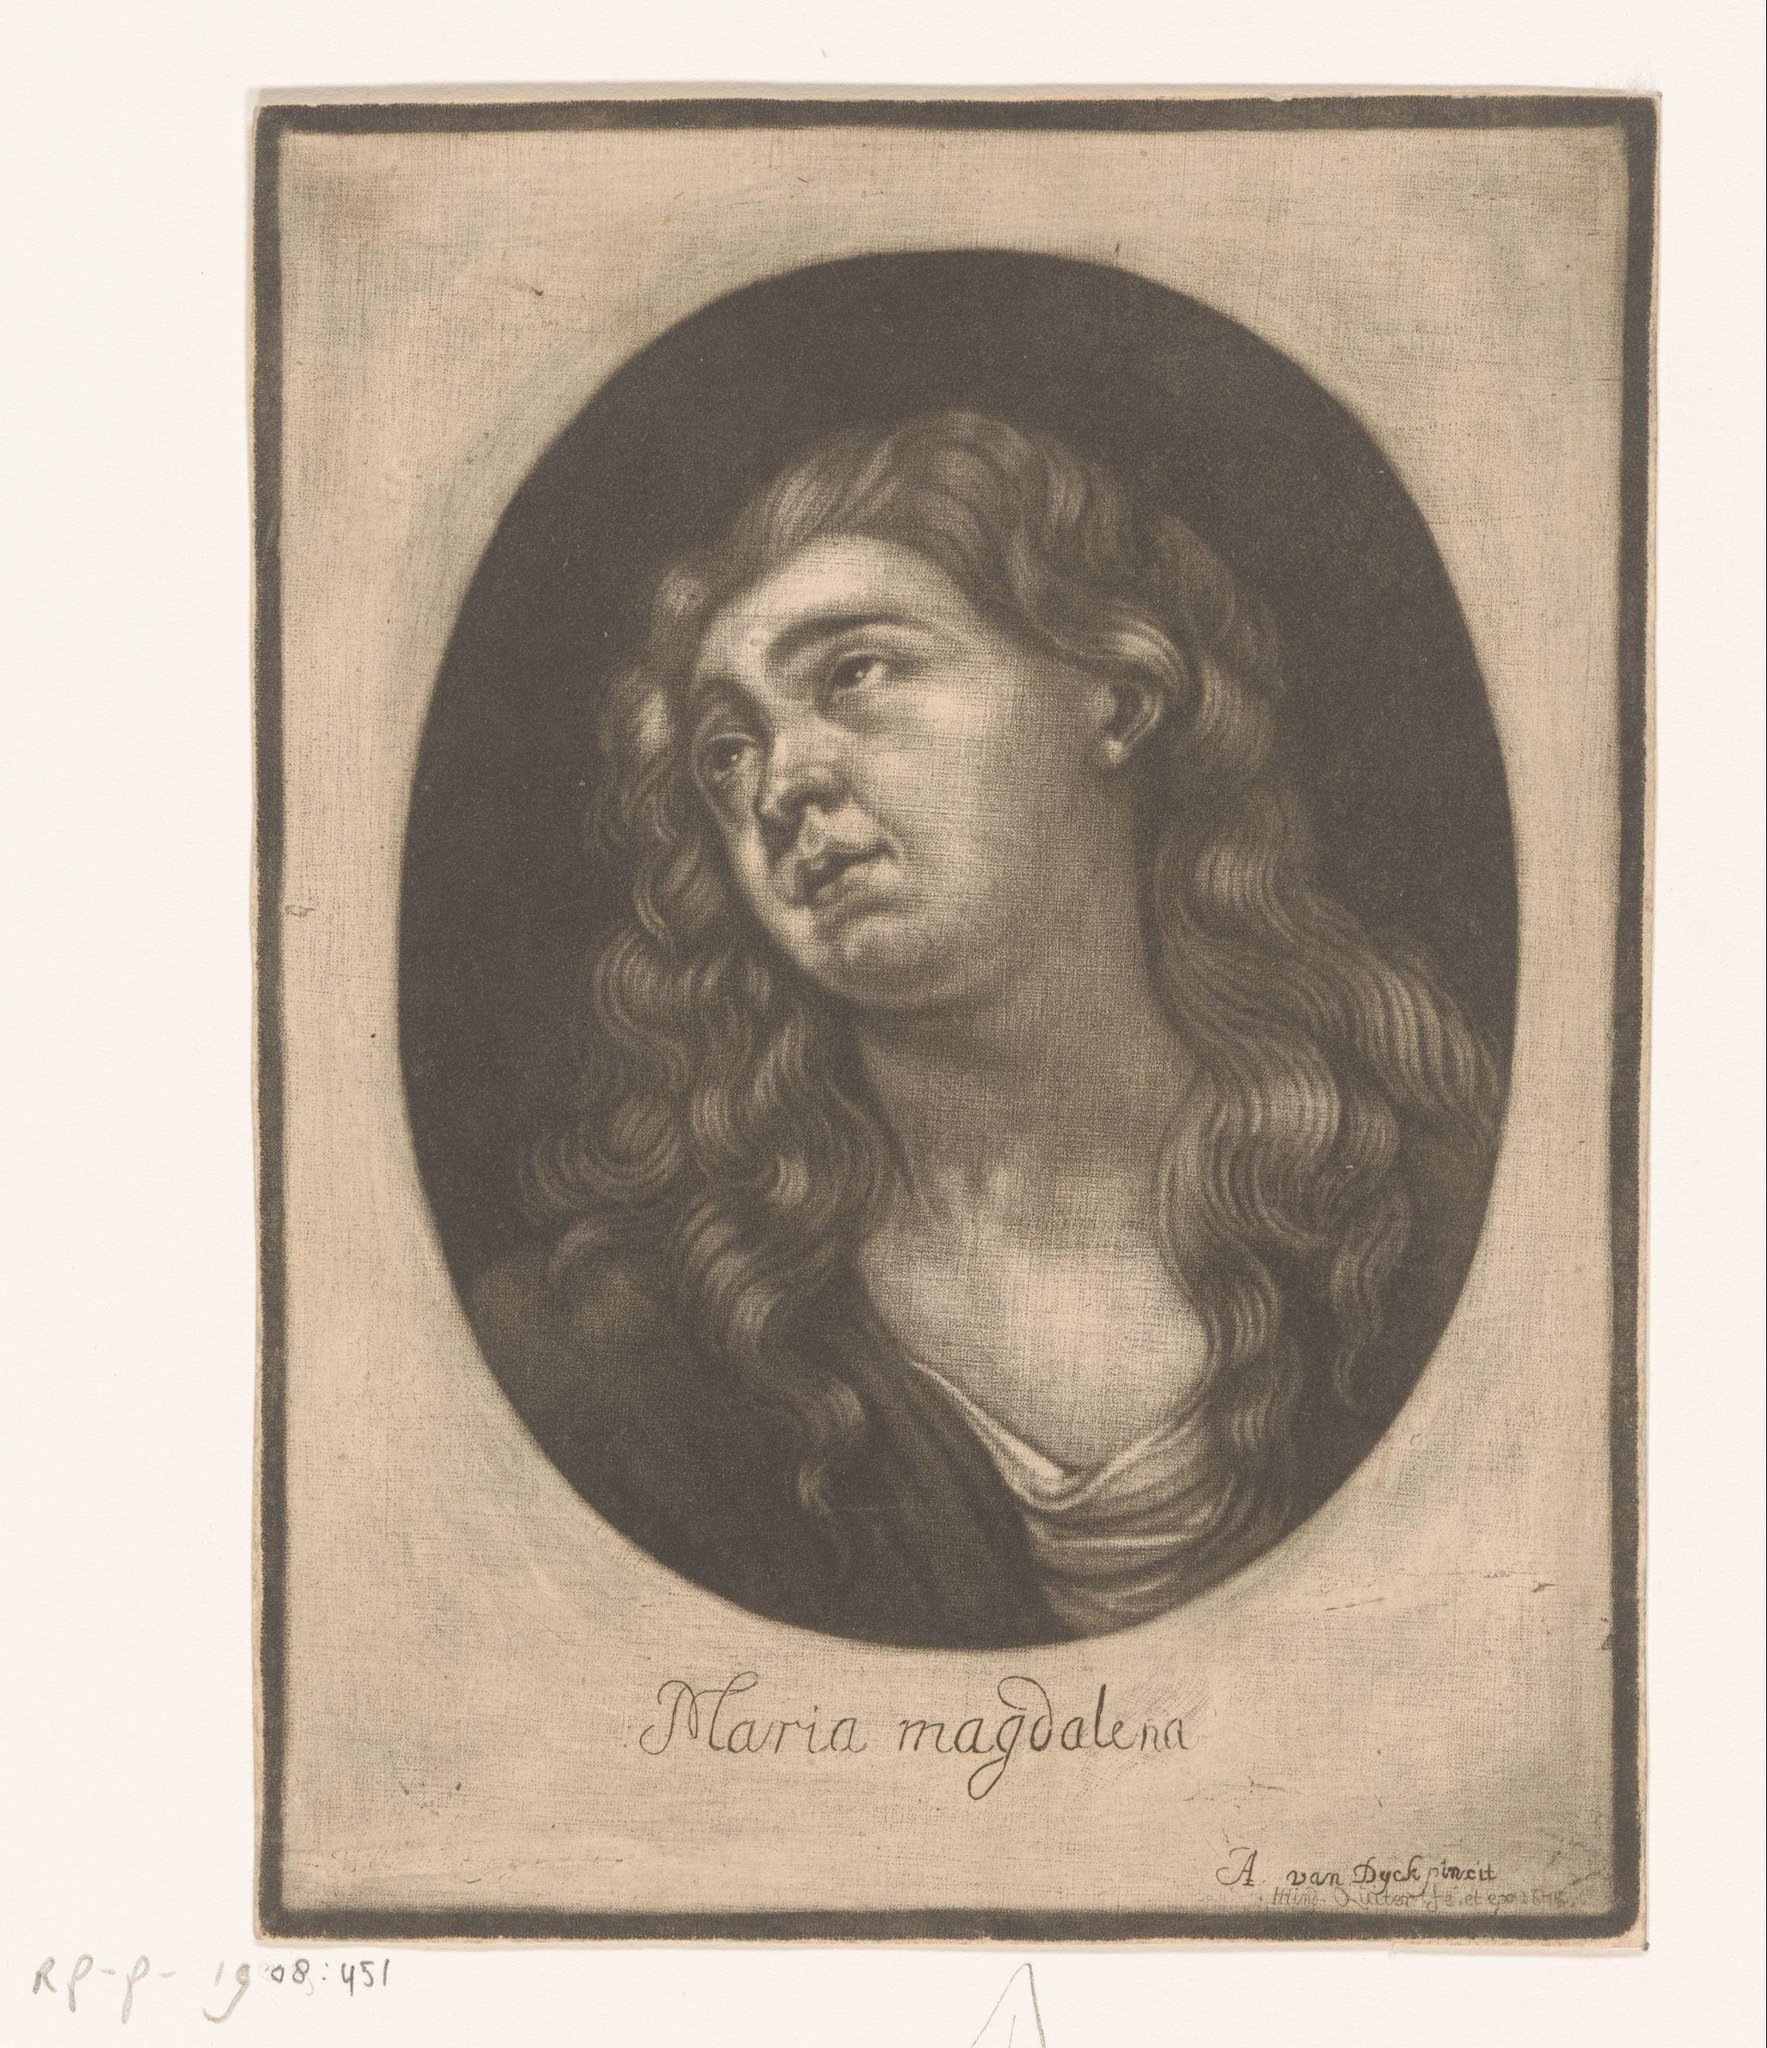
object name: print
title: Borstbeeld van Maria Magdalena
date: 1678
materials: paper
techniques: mezzotint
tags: the penitent harlot mary magdalene; possible attributes: book (or scroll), crown, crown of thorns, crucifix, jar of ointment, mirror, musical instrument, palm-branch, rosary, scourge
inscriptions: collector's mark: Lugt 2228